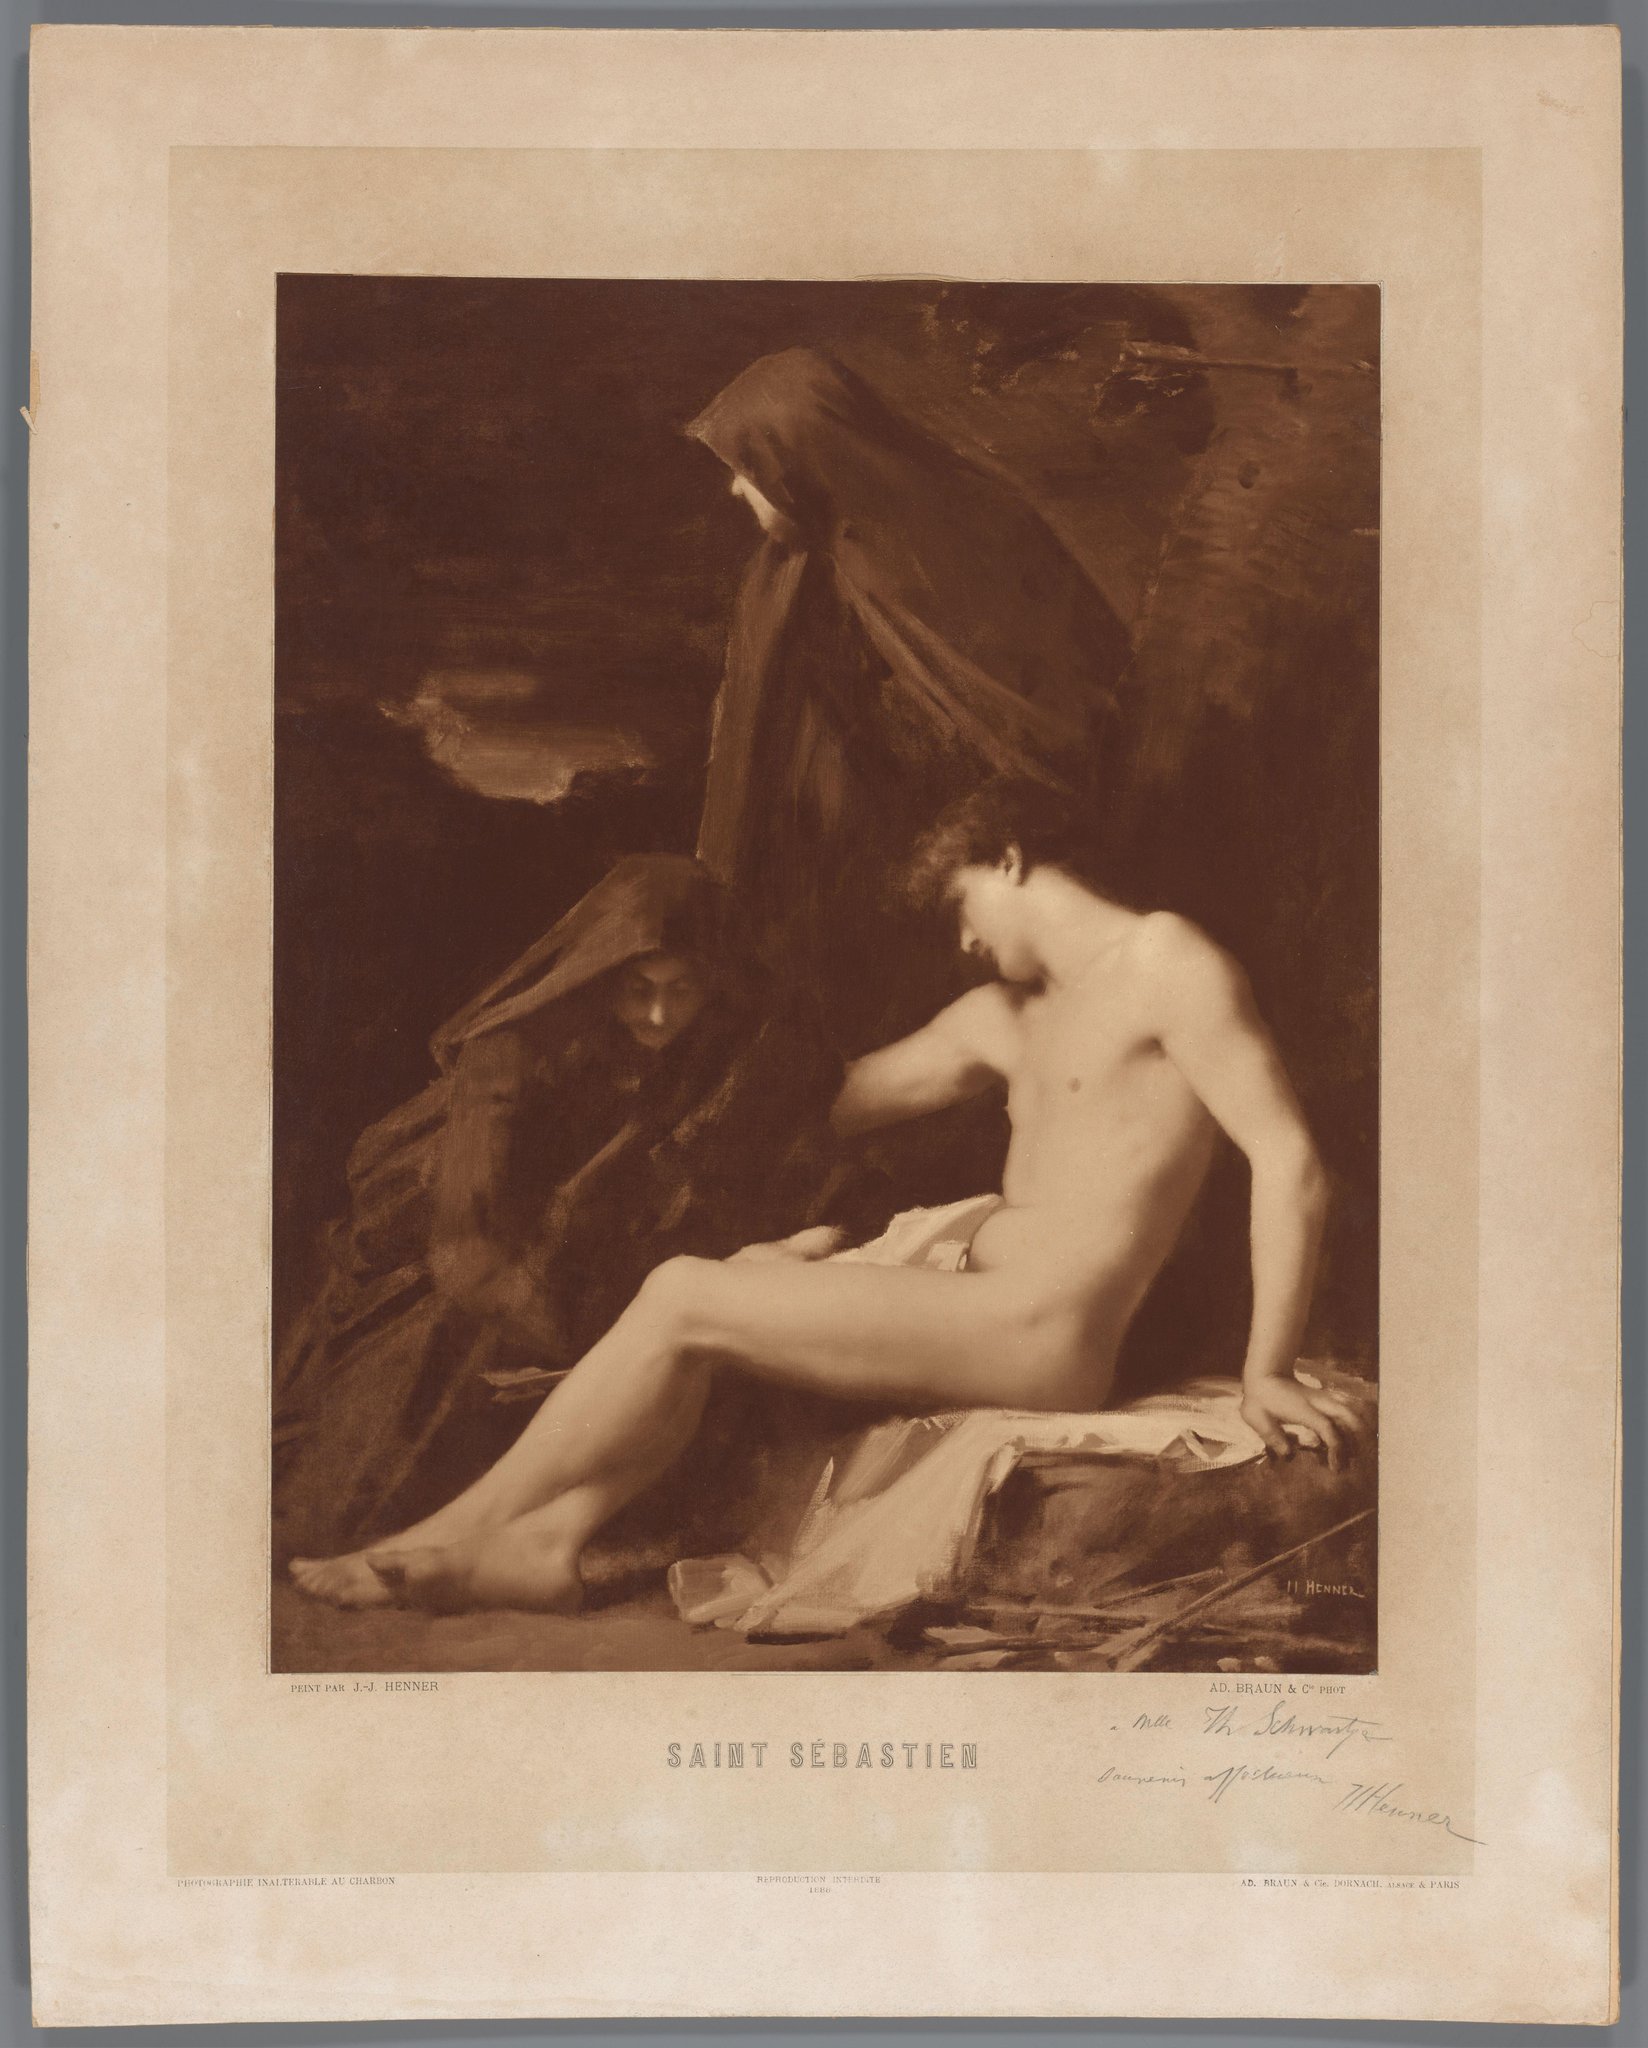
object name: photograph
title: Fotoreproductie van een schilderij van Jean-Jacques Henner, 'Sint Sebastiaan'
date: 1888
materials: cardboard, paper, photographic support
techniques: carbon print